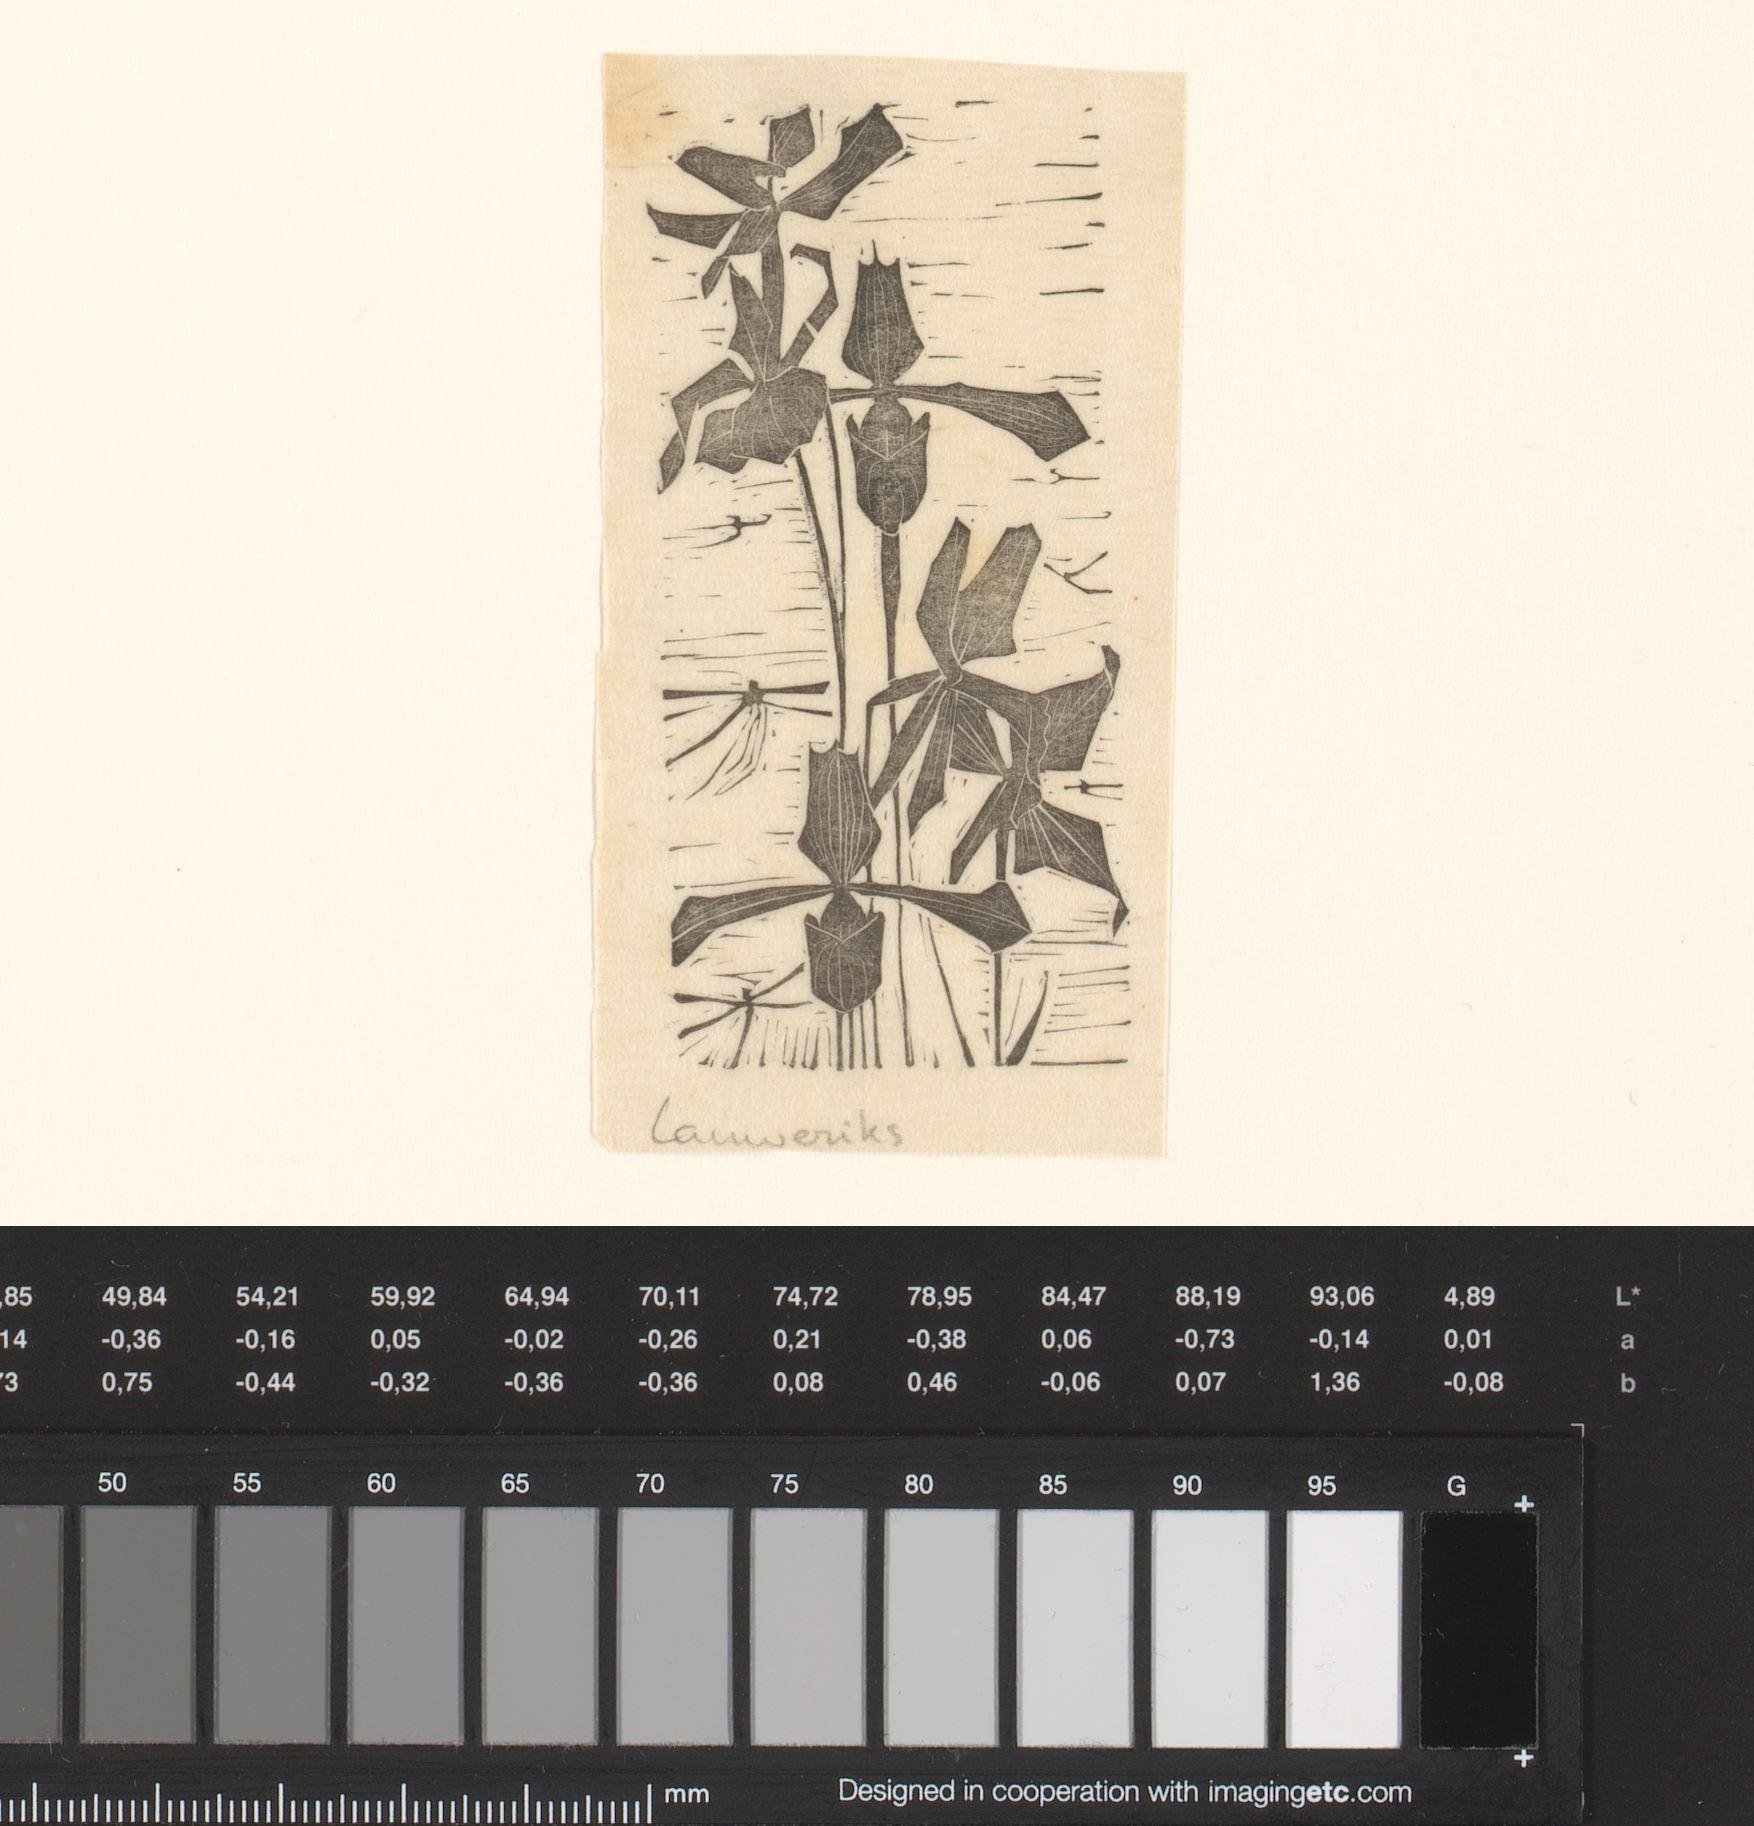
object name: print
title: Orchideeën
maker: mathieu lauweriks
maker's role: designer, draughtsman, print maker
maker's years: 1864-1932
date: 1895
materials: paper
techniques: woodcut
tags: flowers: orchid